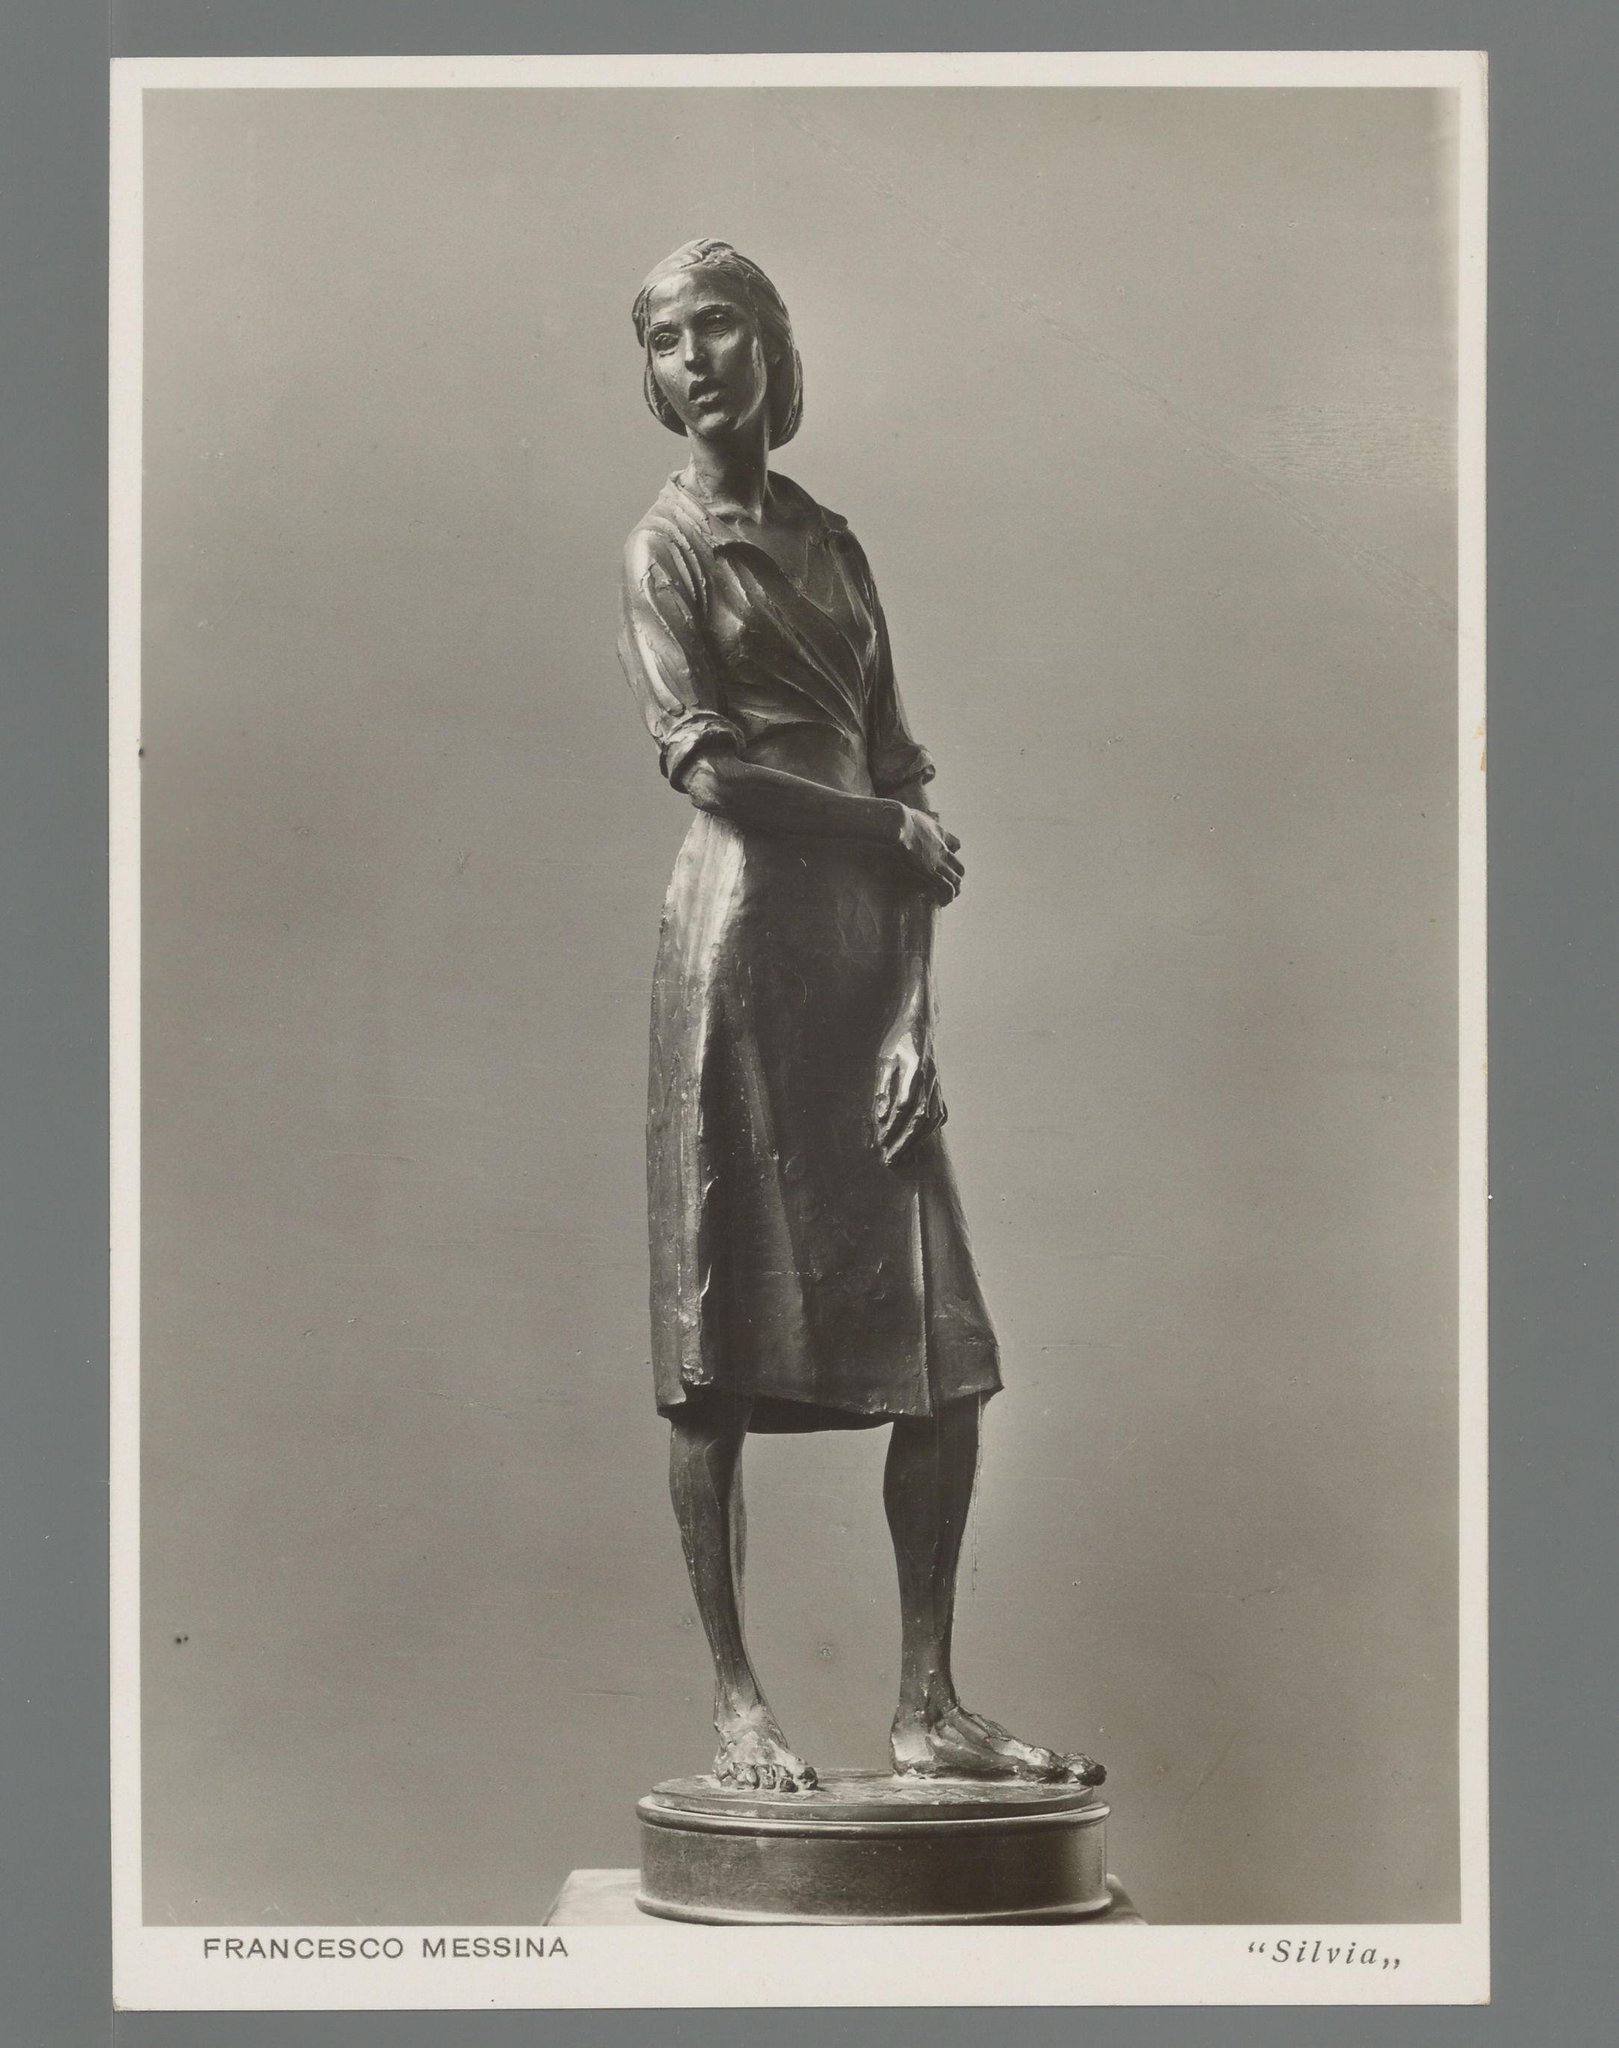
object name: ansichtkaart, prentbriefkaart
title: Francesco Messina. "Silvia"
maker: mario crimella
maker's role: fotograaf, fotostudio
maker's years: 1893-1964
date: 1935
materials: photographic support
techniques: photography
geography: milan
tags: adult woman, sculpture